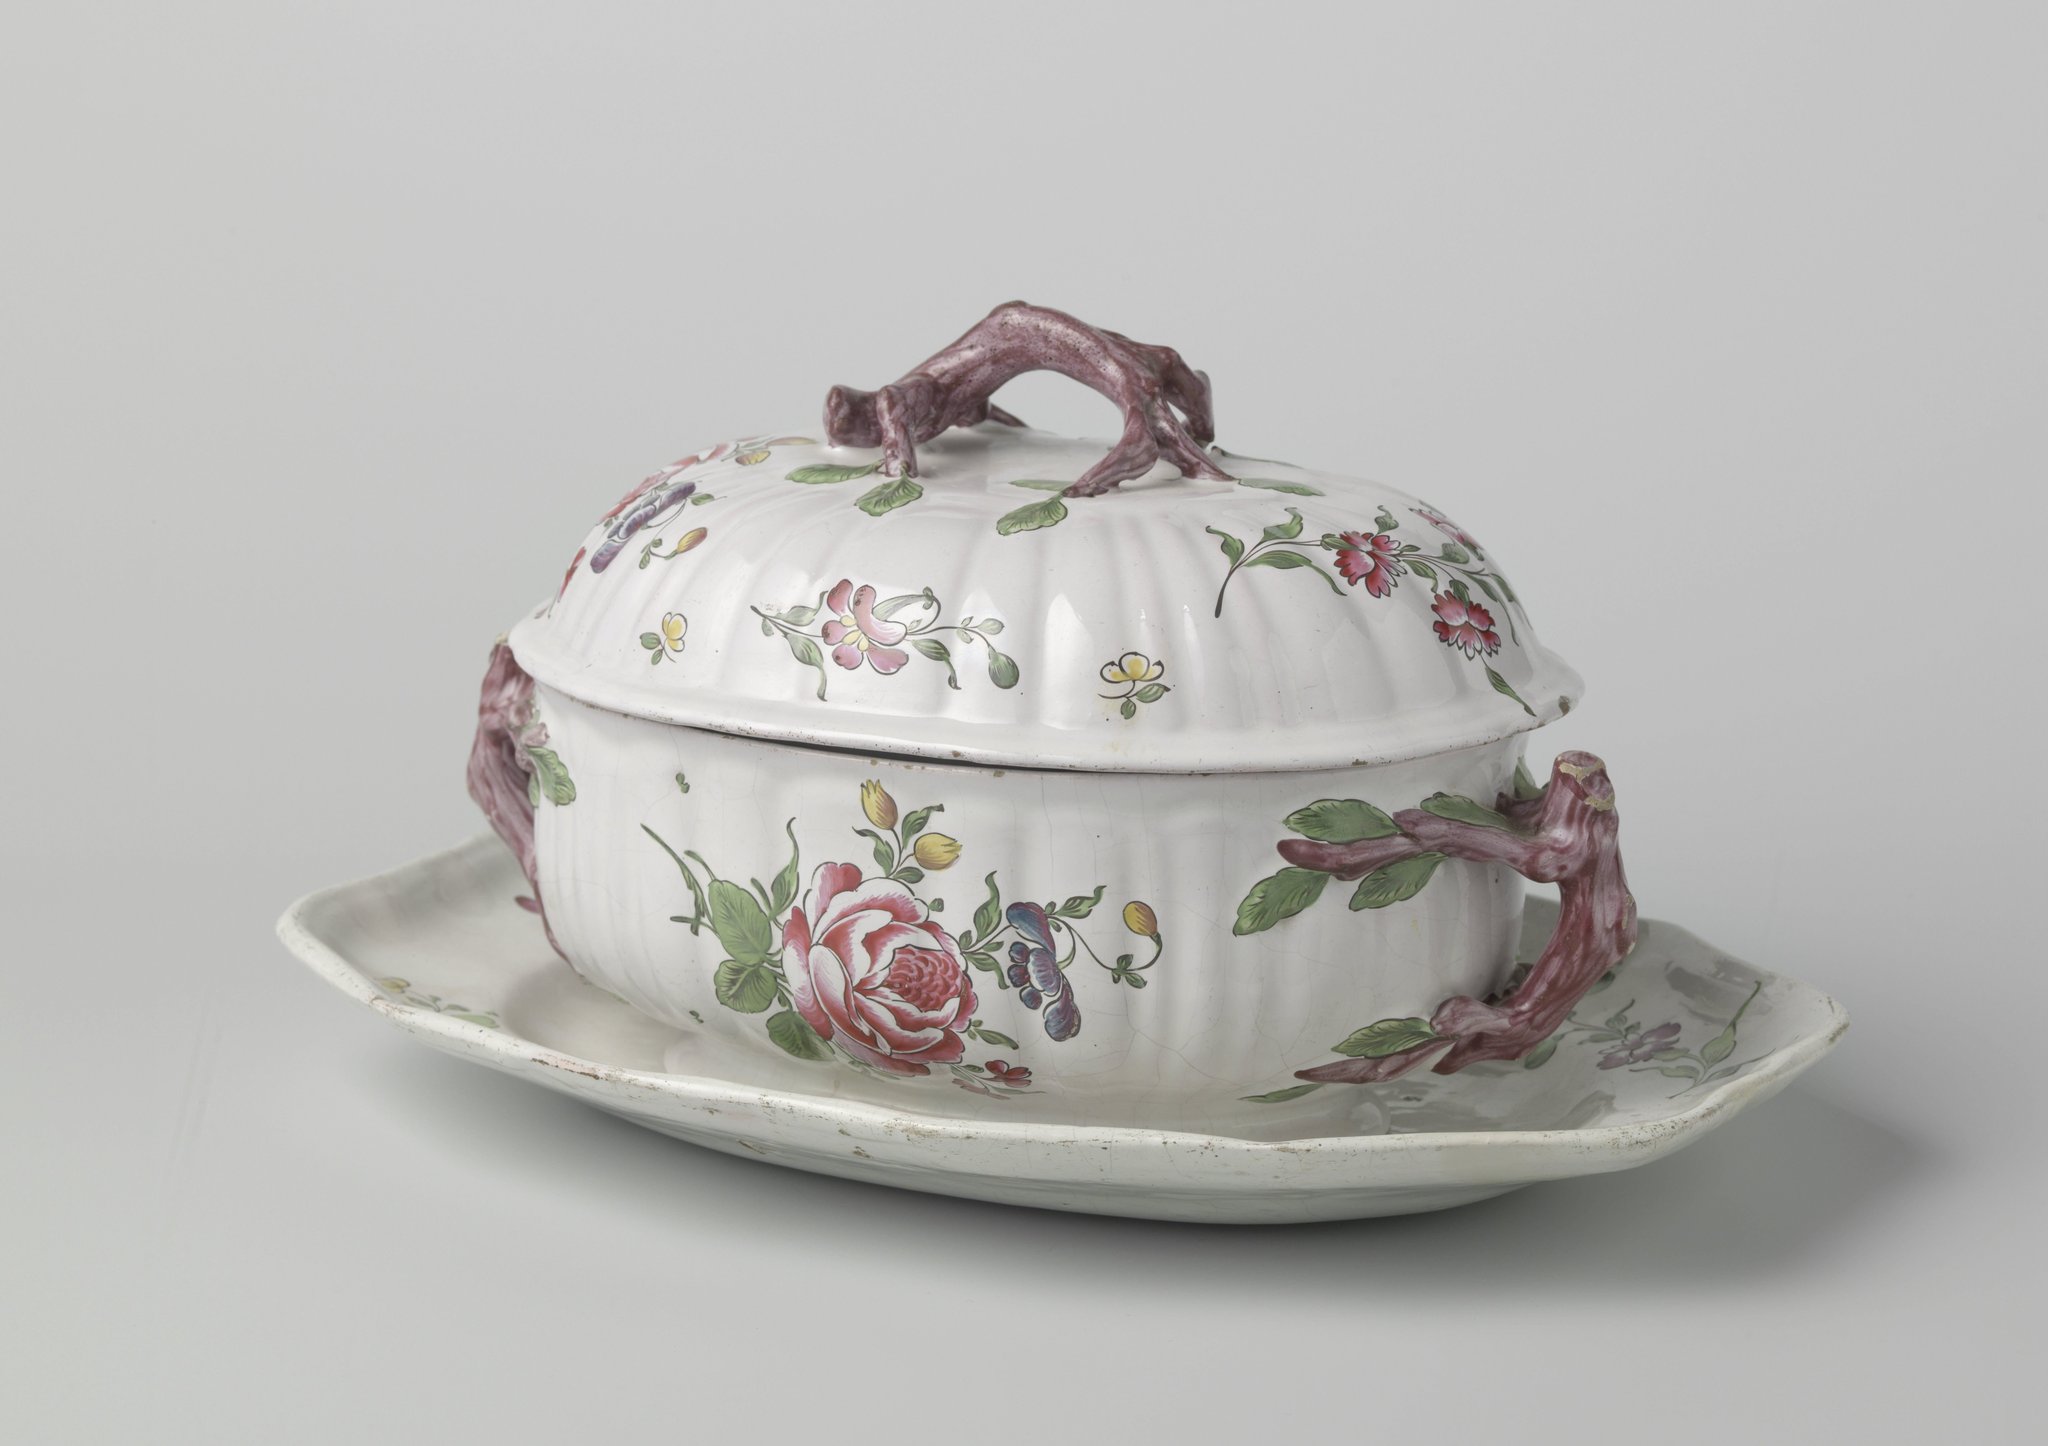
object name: tureen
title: Terrine met deksel, op onderschotel, beschilderd met bloemtakken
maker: Anonymous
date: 1760-1790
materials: earthenware, glaze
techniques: painted, polychromy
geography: france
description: Ovale terrine van veelkleurig beschilderde faience, op een onderschotel. De terrine is geribd, staat op een voet en heeft een deksel. De oren van de terrine en van het deksel hebben de vorm van een boomtak die met bladeren op de terrine en deksel zijn bevestigd. De onderschotel heeft een gelobde rand. De terrine, deksel en onderschotel zijn beschilderd met bloemtakken.